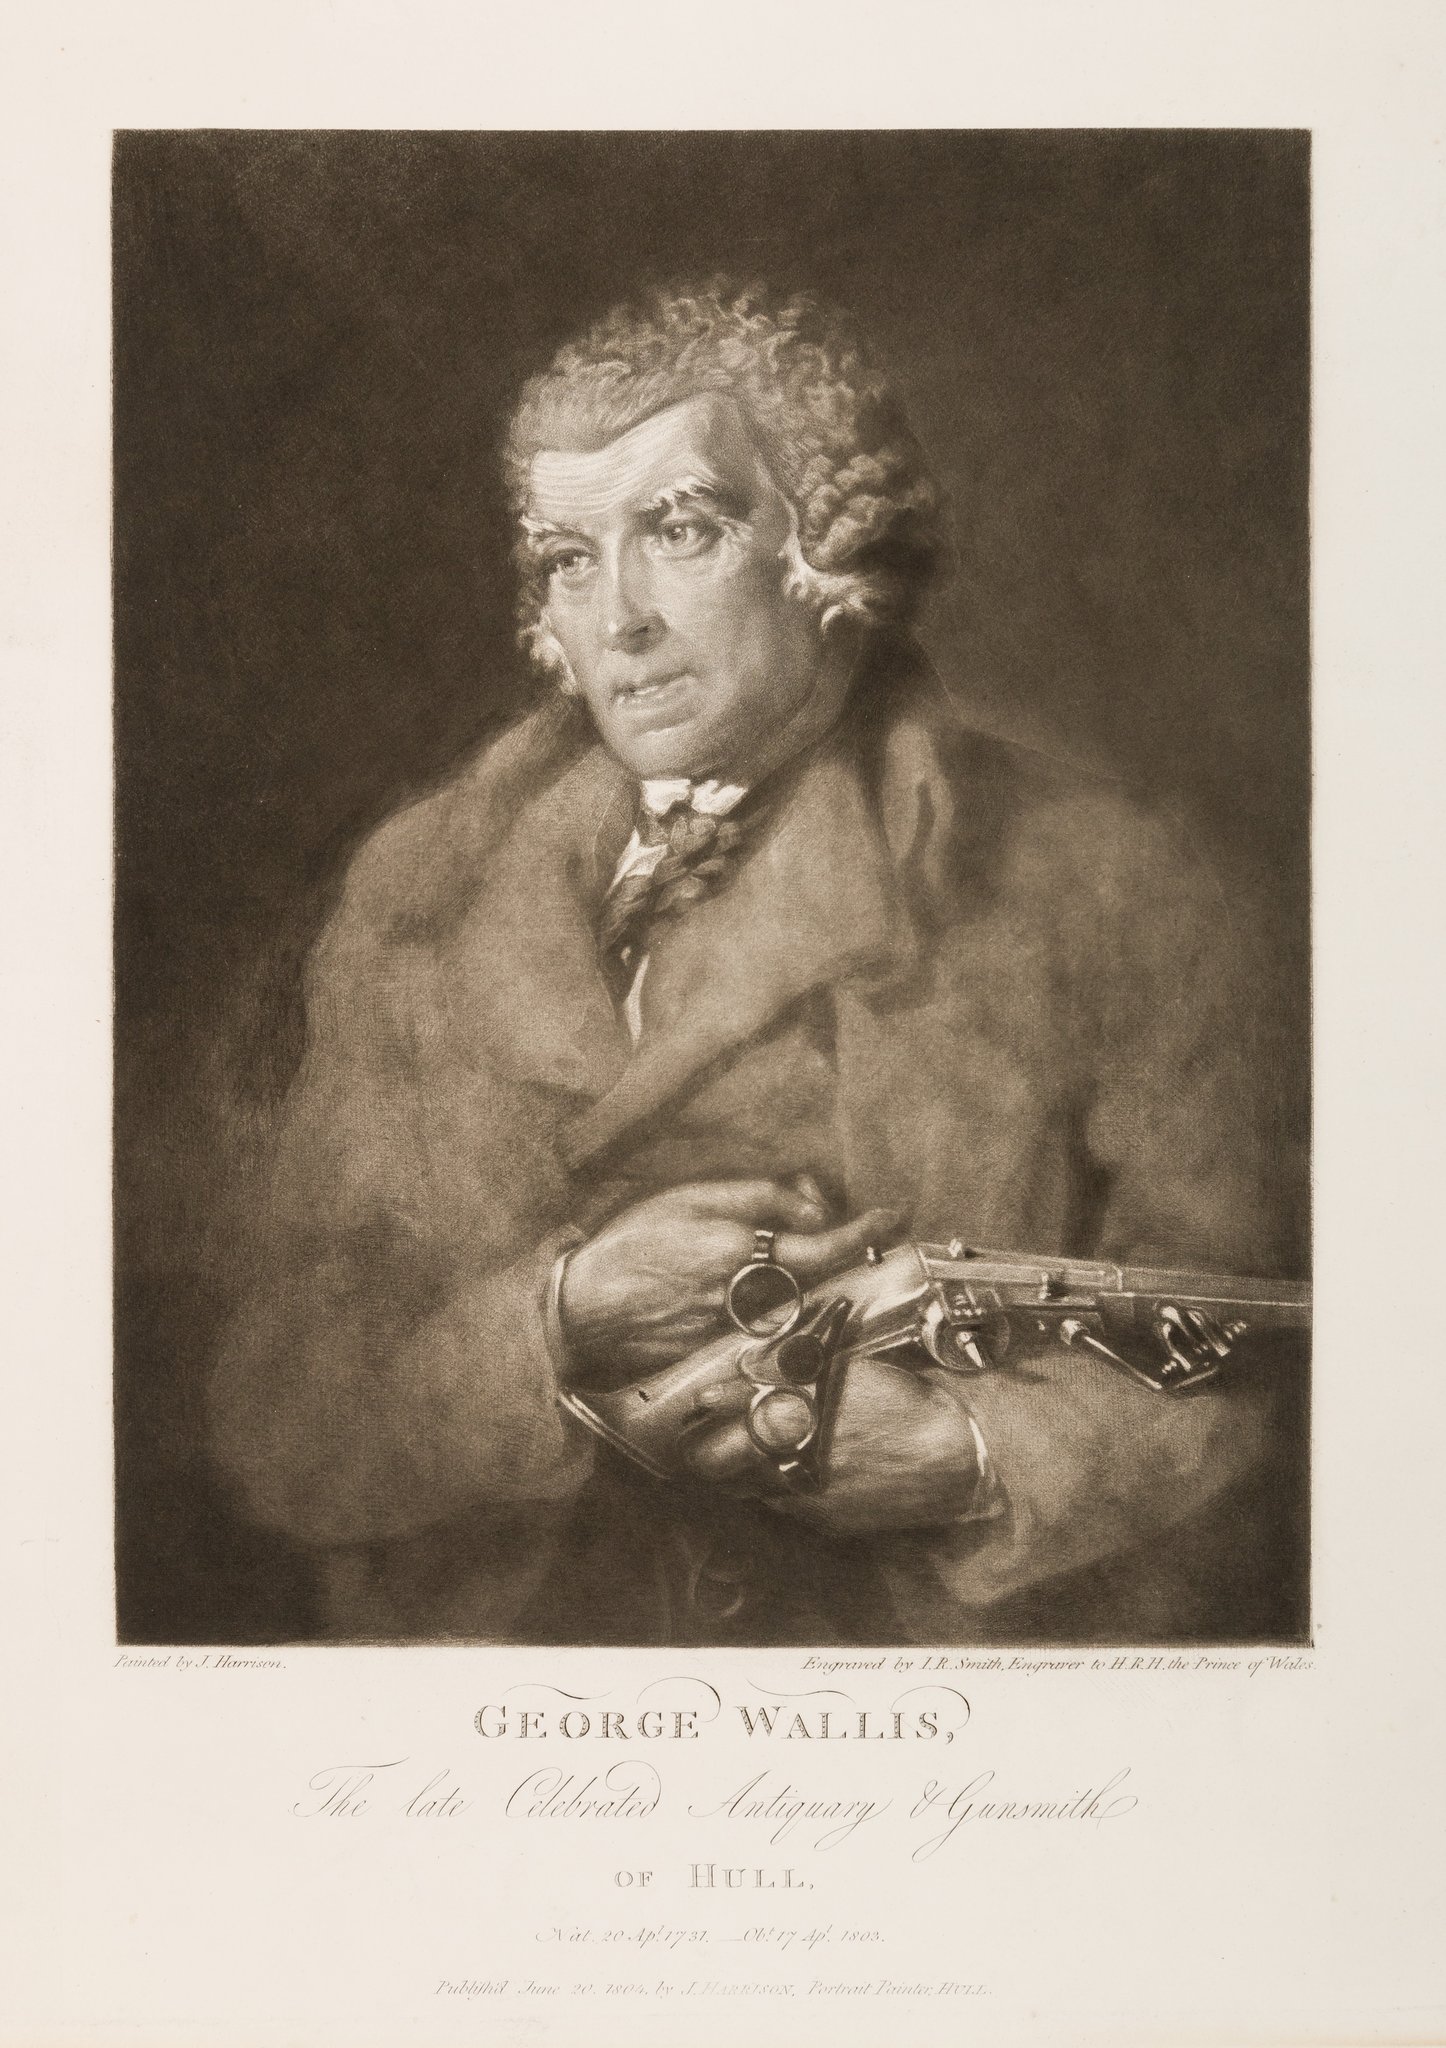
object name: mezzotint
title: George Wallis, The Late Celebrated Antiquary and Gunsmith of Hull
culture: british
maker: john raphael smith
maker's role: engraver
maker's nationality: british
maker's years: 1751-1812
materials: paper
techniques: mezzotint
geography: england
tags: firearms,men,portraits